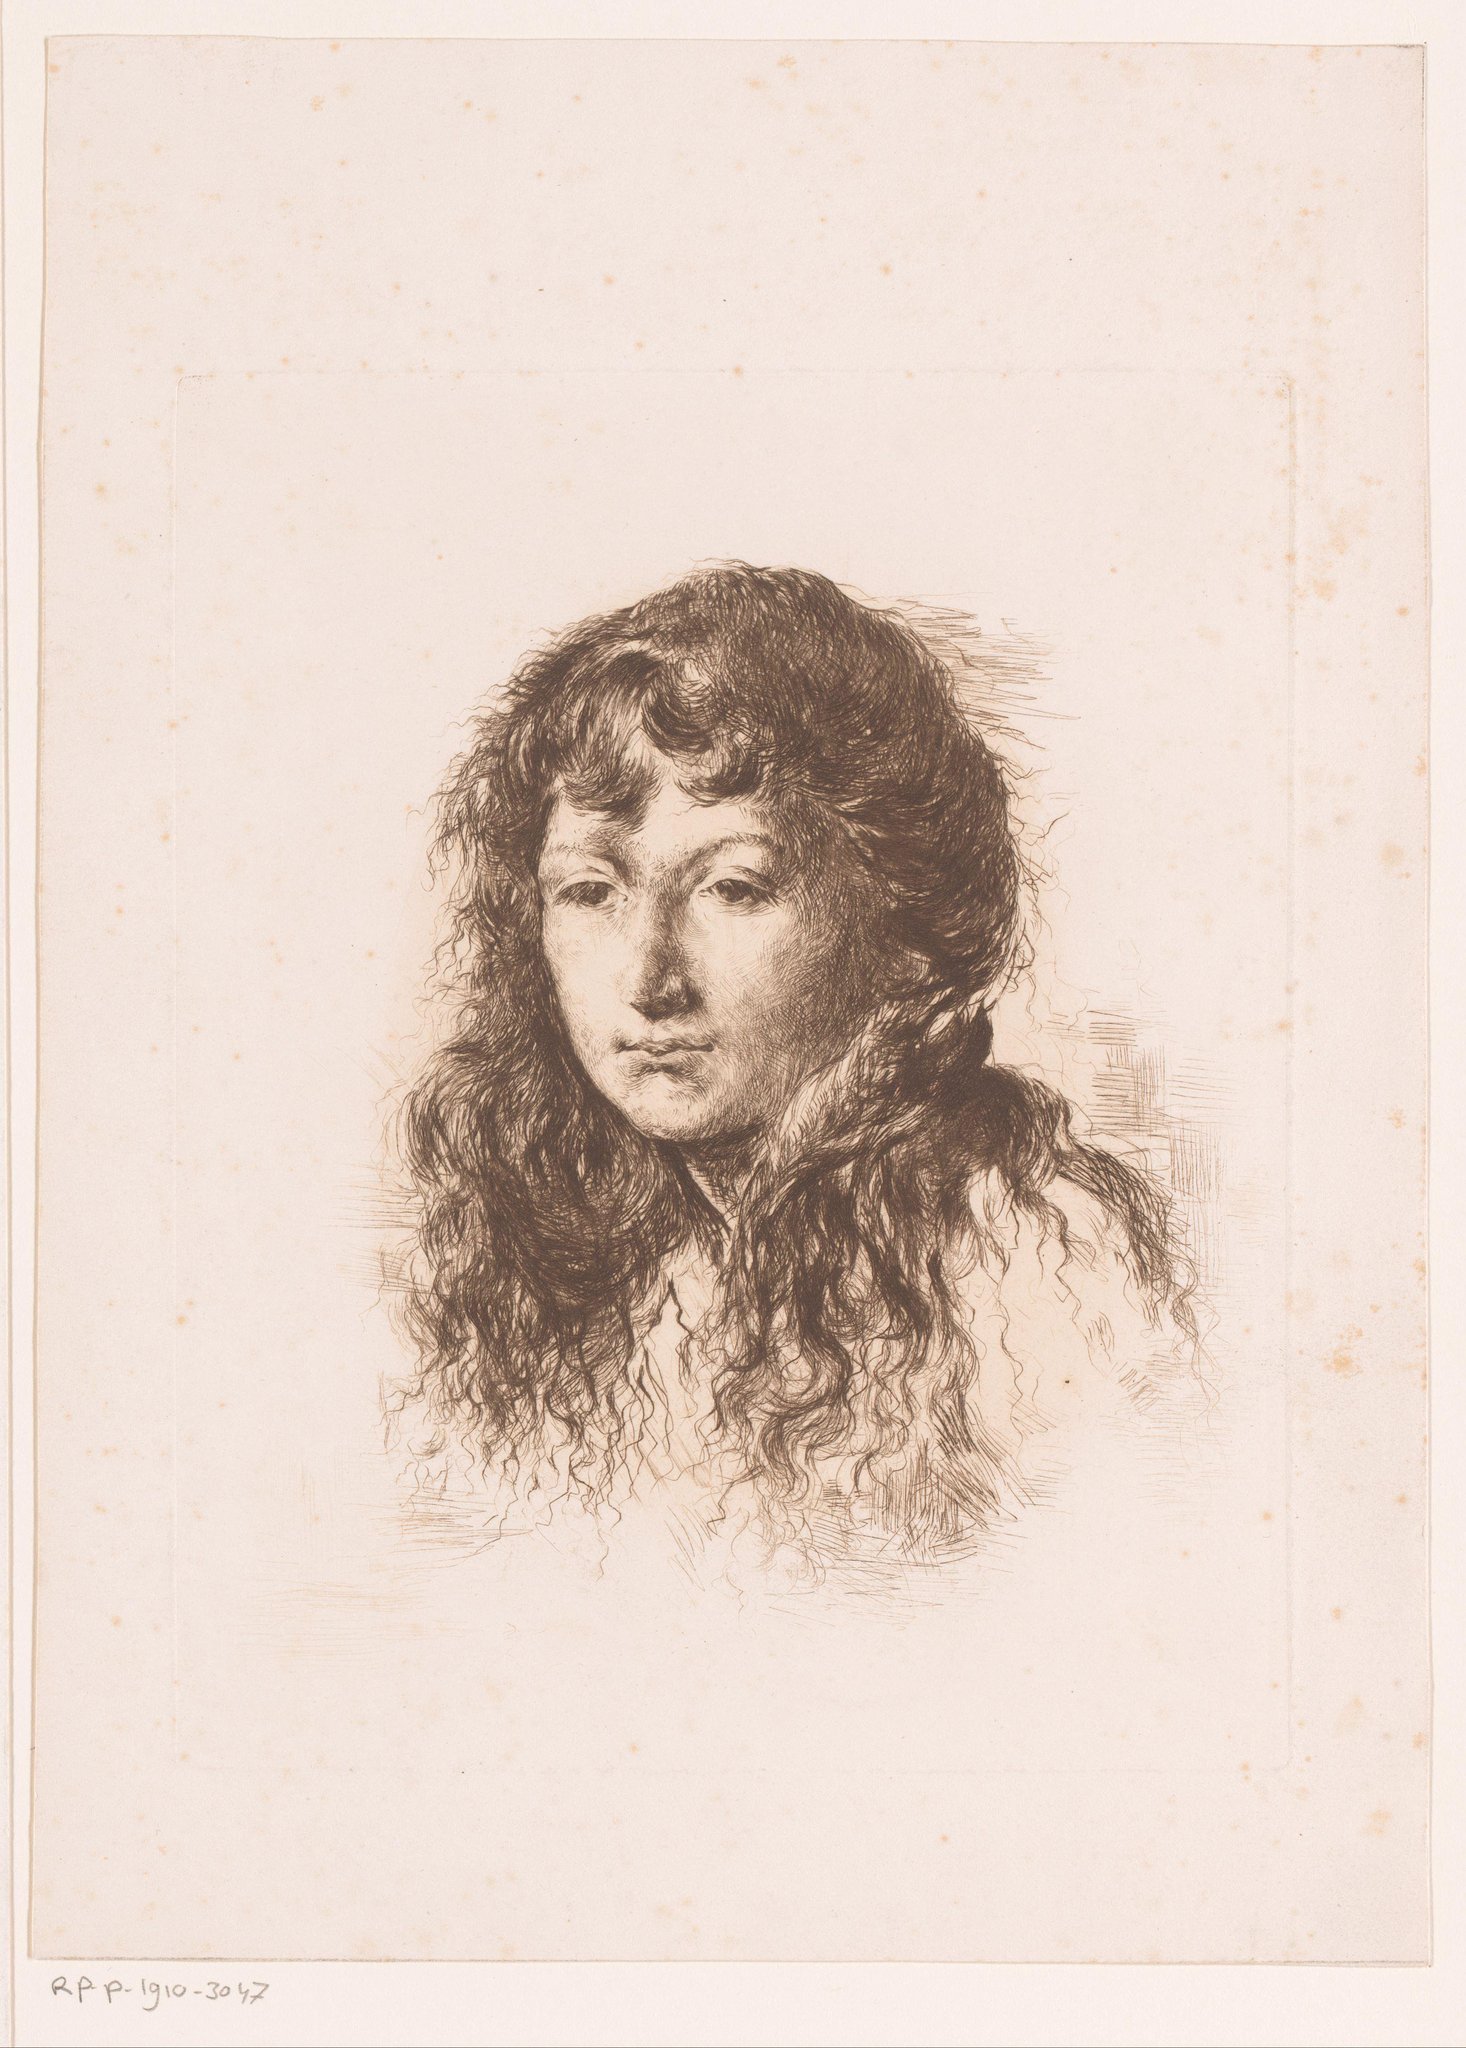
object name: print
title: Portret van een onbekend meisje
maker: piet van engelen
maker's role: print maker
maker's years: 1863-1924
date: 1873-1910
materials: paper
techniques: etching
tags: historical persons, girl (child between toddler and youth)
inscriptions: collector's mark: Lugt 2228